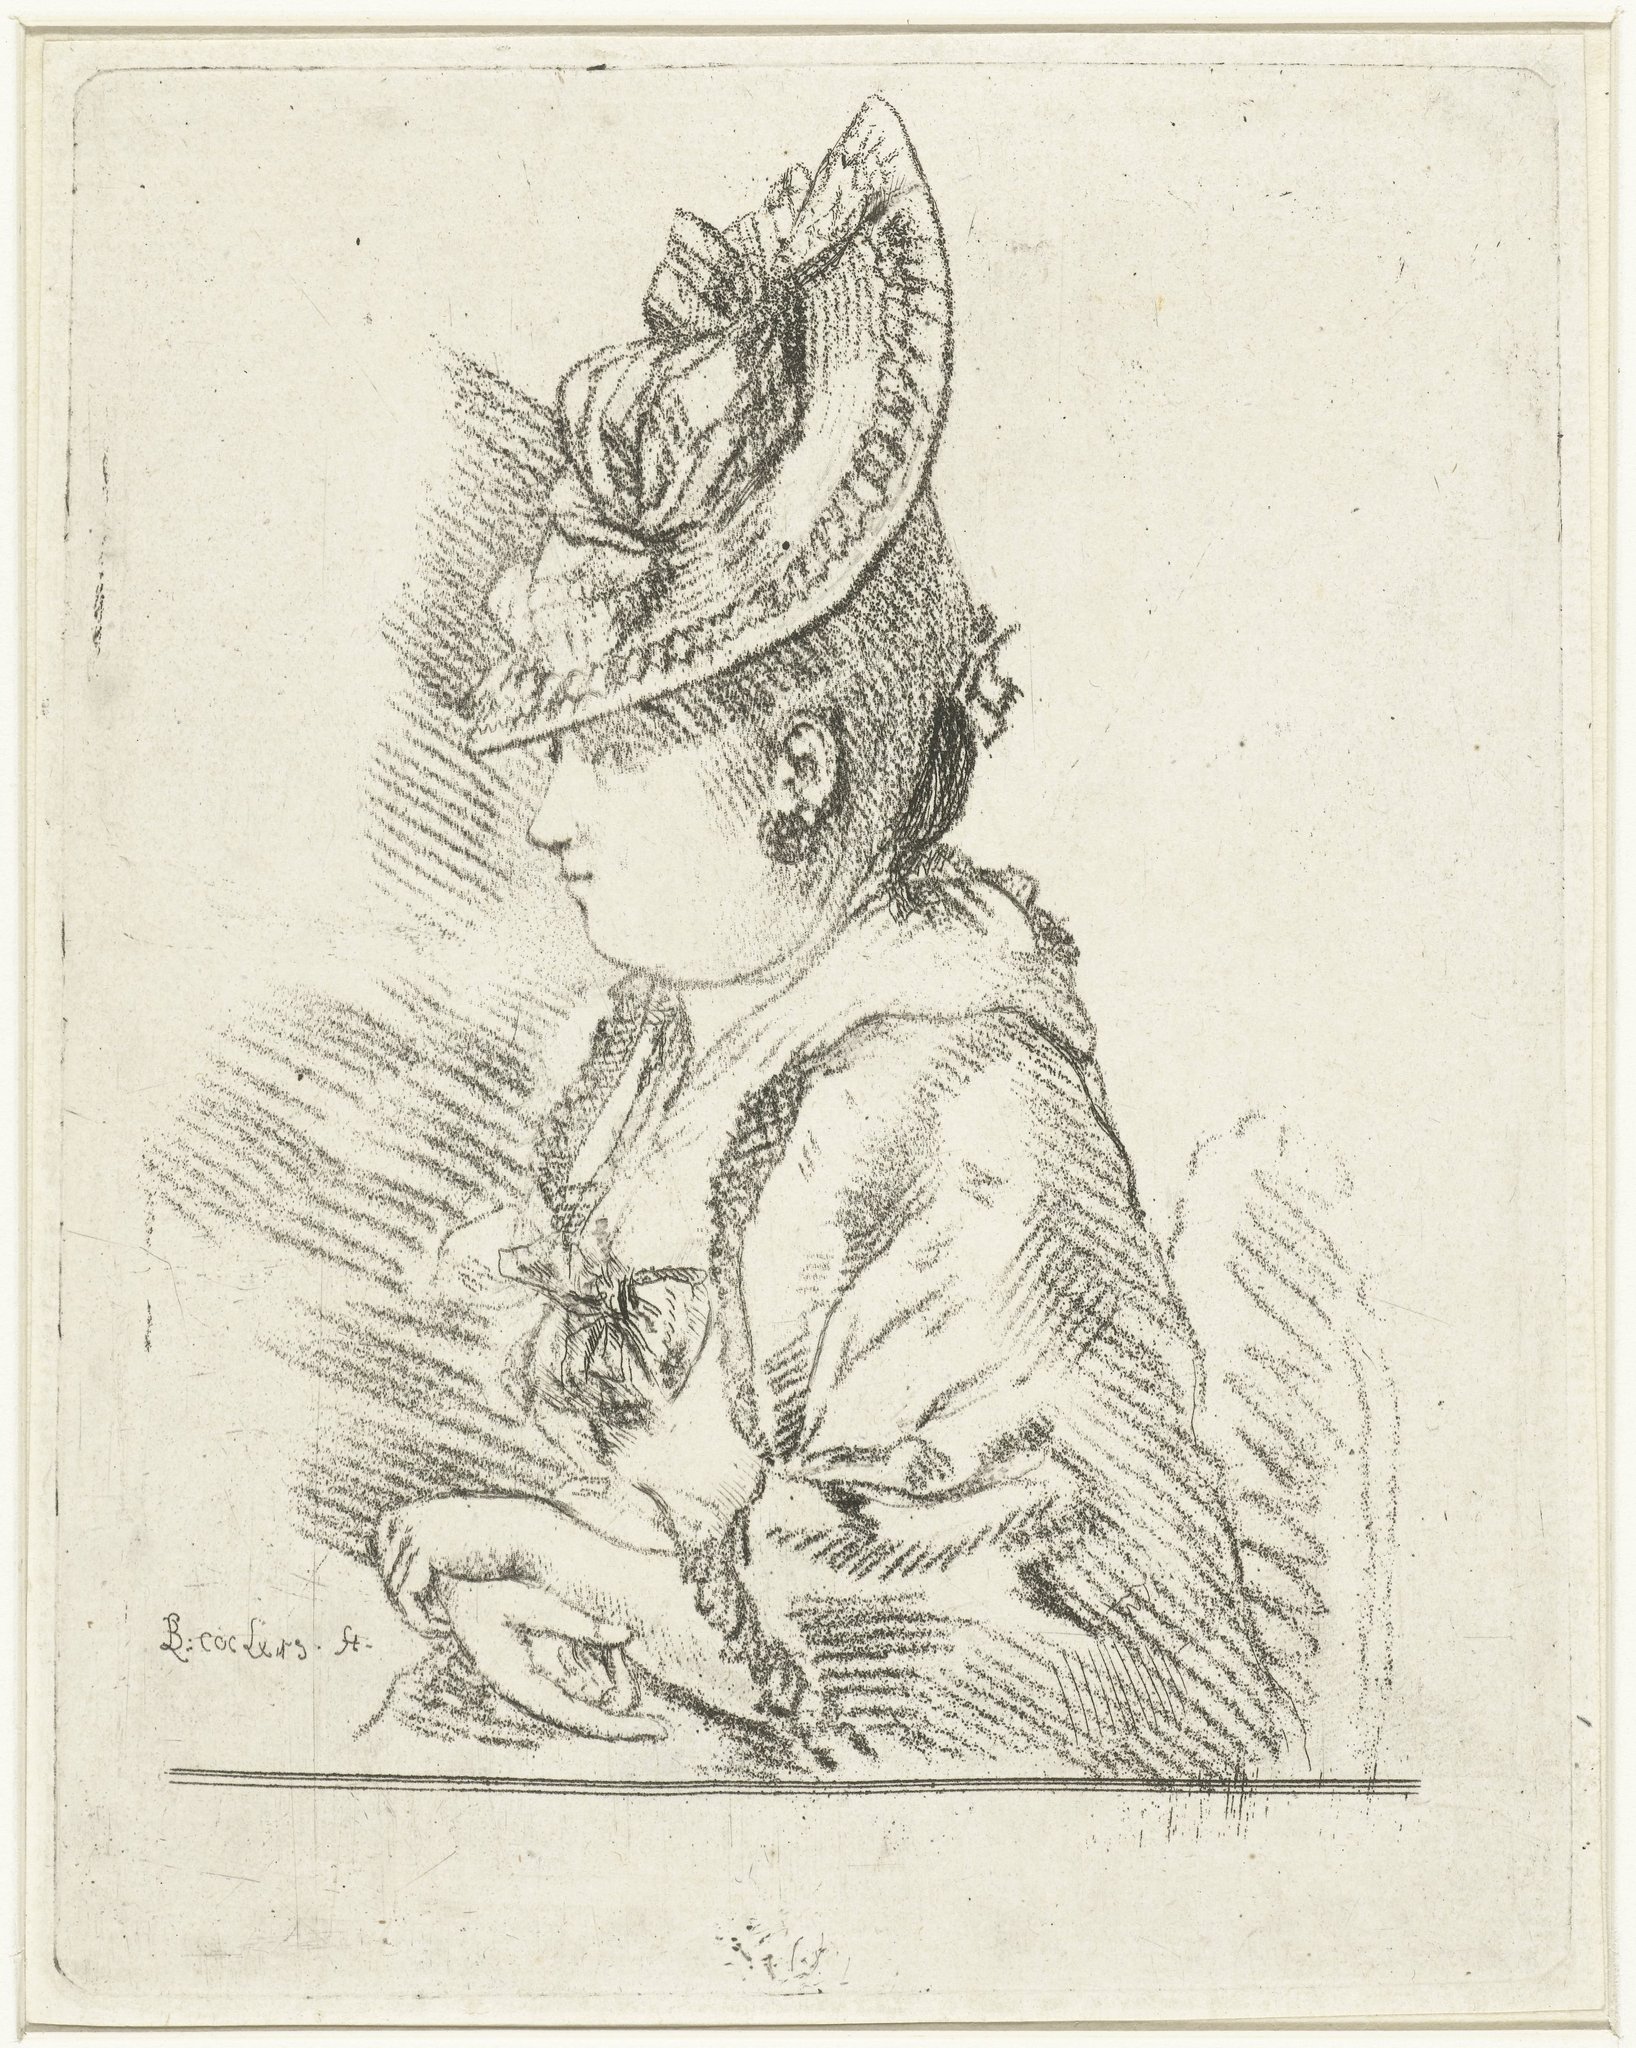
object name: print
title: Portret van een jonge dame met hoed in profiel naar links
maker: louis bernard coclers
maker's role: draughtsman, print maker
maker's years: 1741-1817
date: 1756-1817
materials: paper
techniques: printmaking, drypoint, etching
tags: anonymous historical person portrayed alone - bb - woman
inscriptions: collector's mark: Lugt 2228